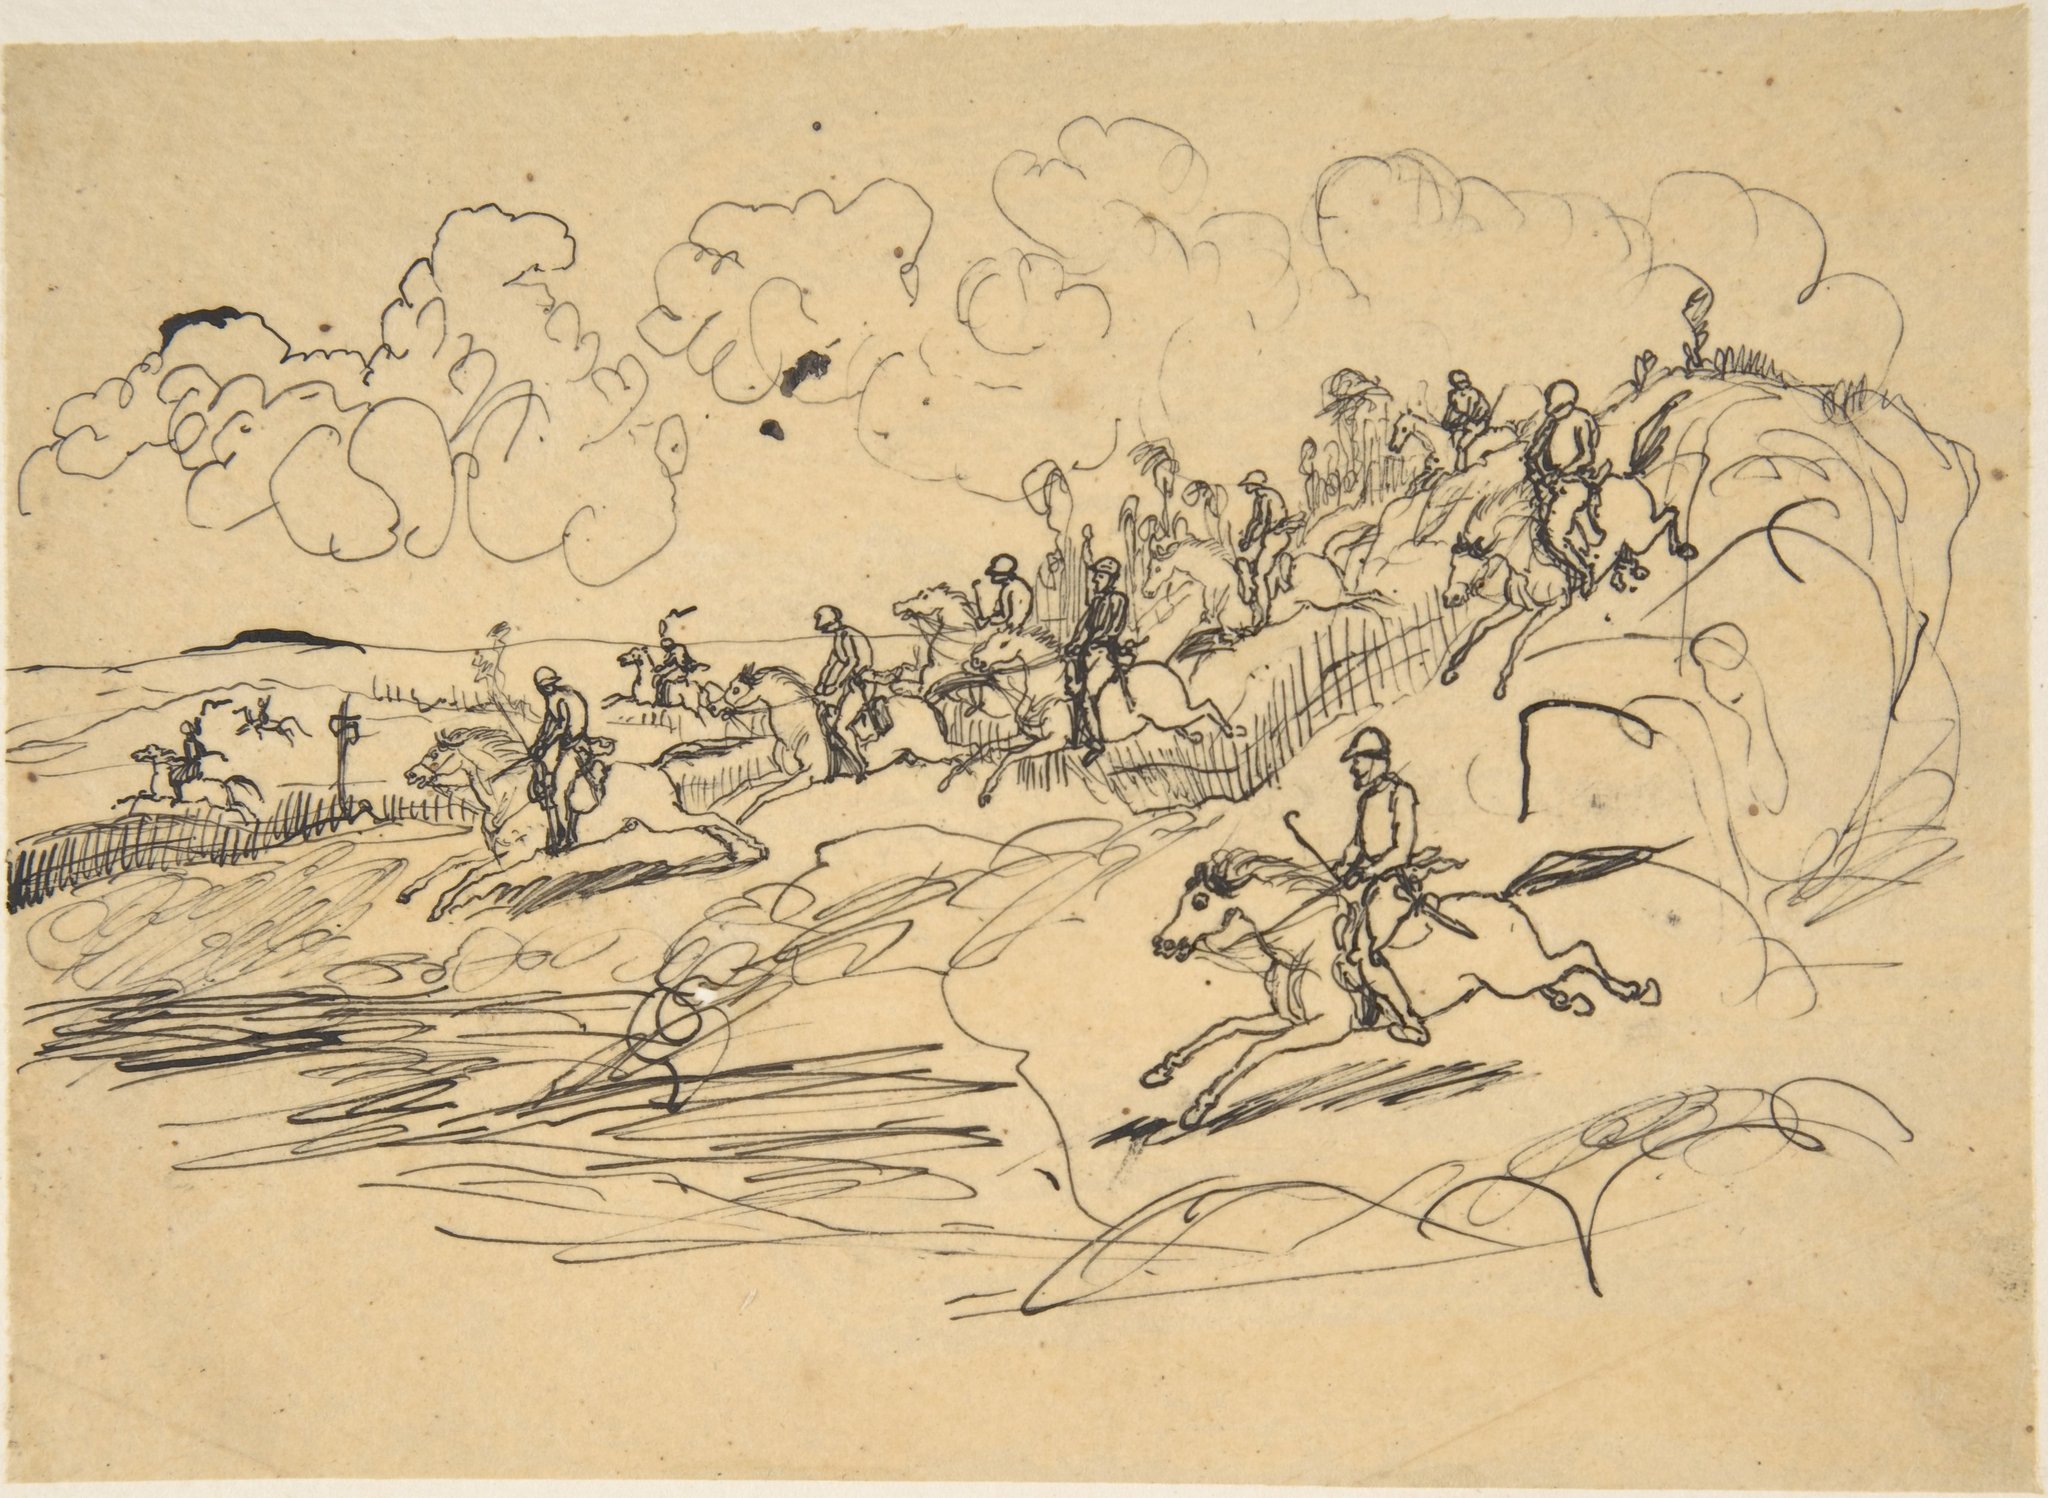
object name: drawing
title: The Hunt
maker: rodolphe bresdin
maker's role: artist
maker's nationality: french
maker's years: 1822-1885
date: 1822-1885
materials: ink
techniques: pen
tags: men,hunting,horses